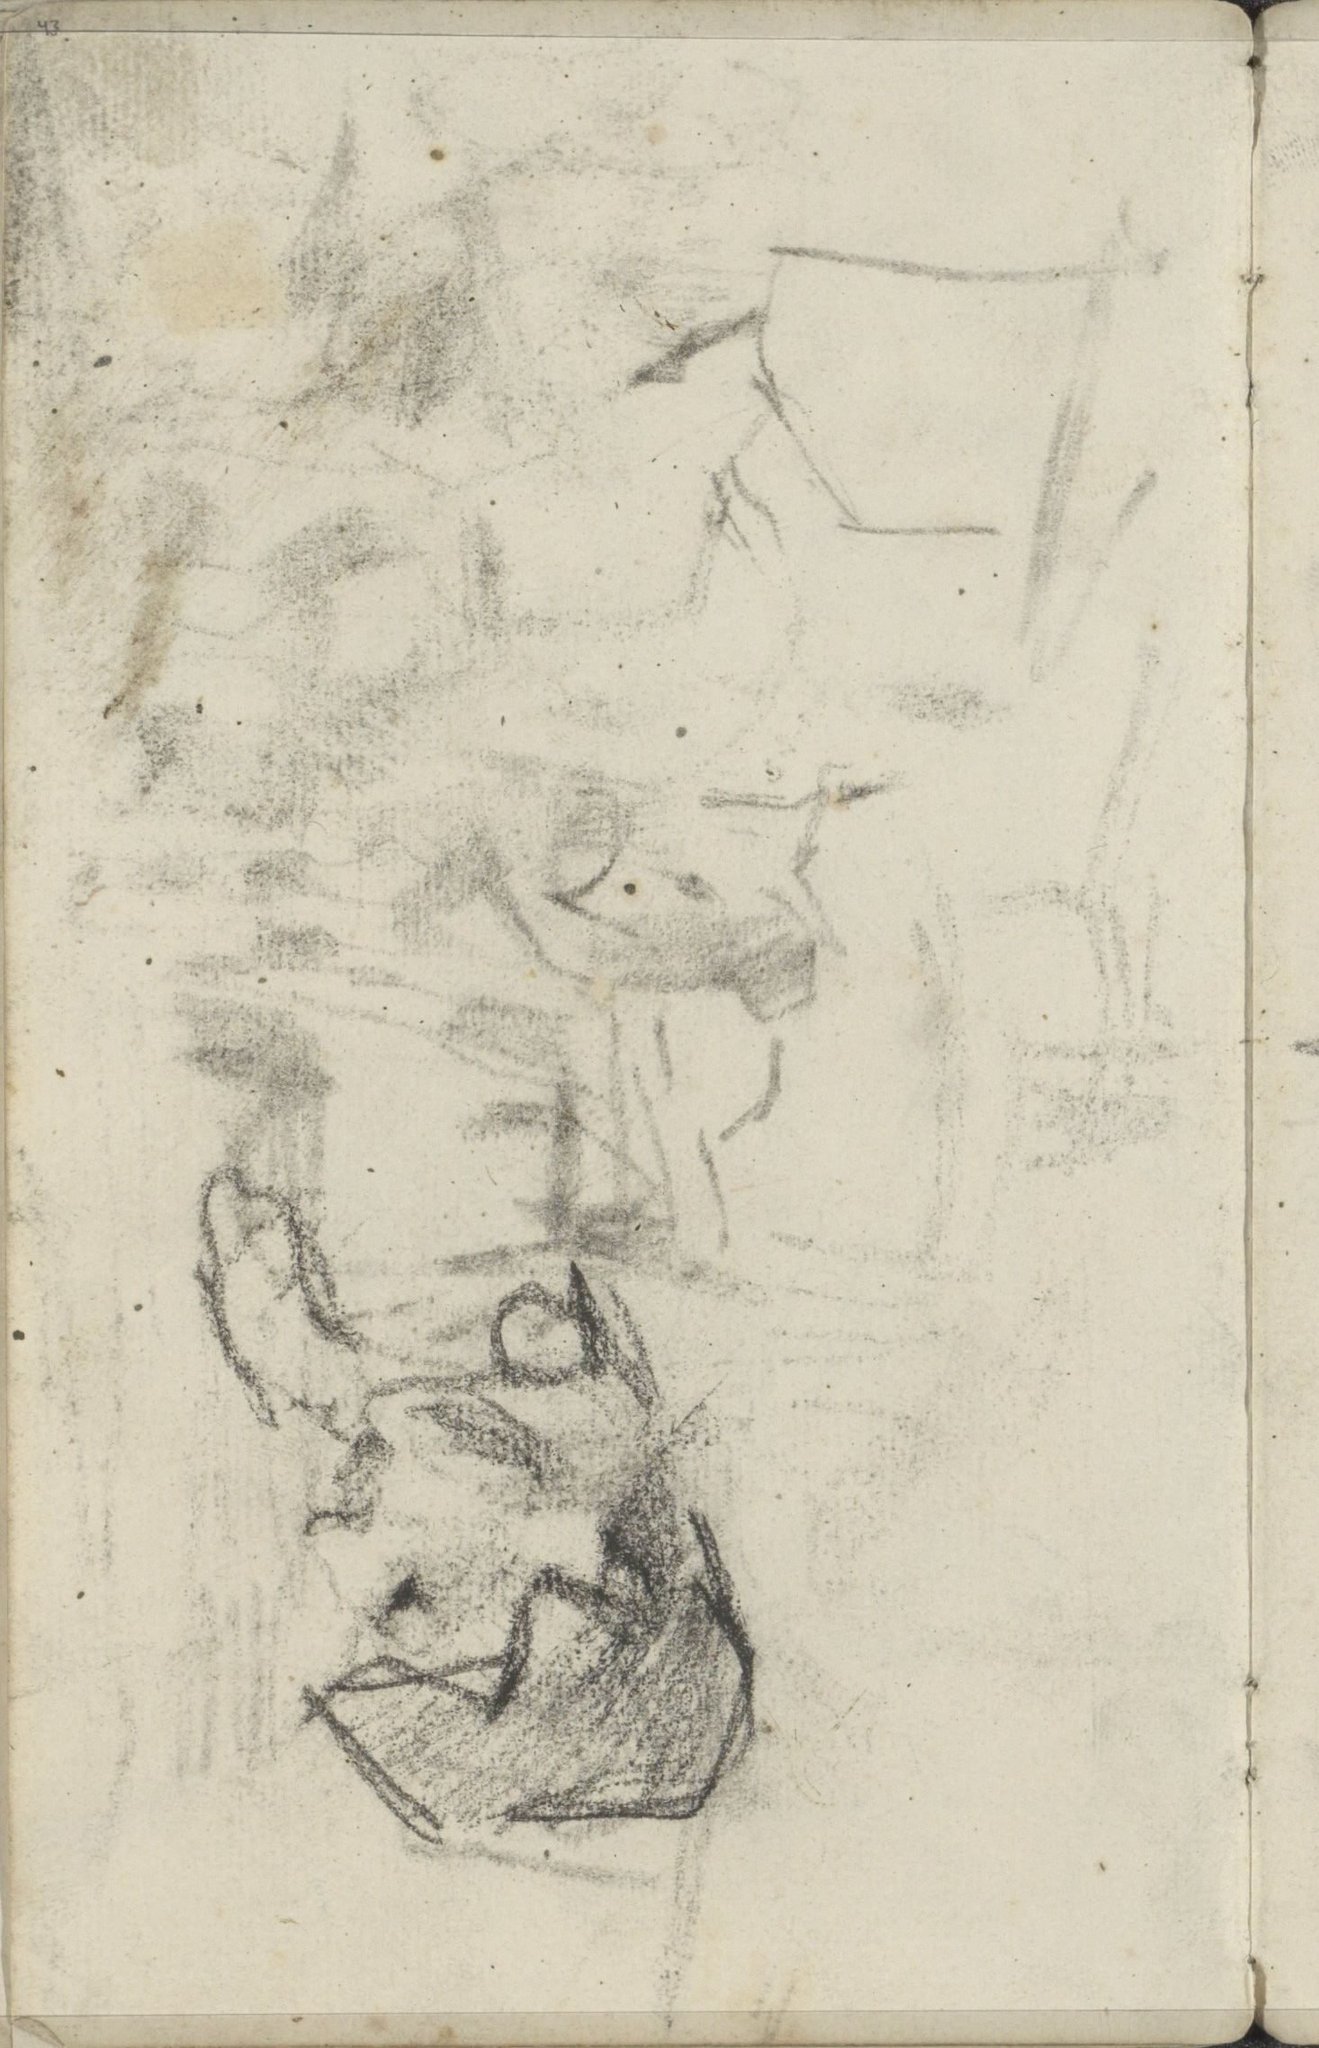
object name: sketchbook leaf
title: Mannenhoofd, in profiel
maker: george hendrik breitner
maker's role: draughtsman, painter, print maker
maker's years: 1857-1923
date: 1884-1886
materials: chalk, paper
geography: paris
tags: head (human) (+ sideview, profile)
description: Pagina 43 uit een schetsboek met 25 bladen.